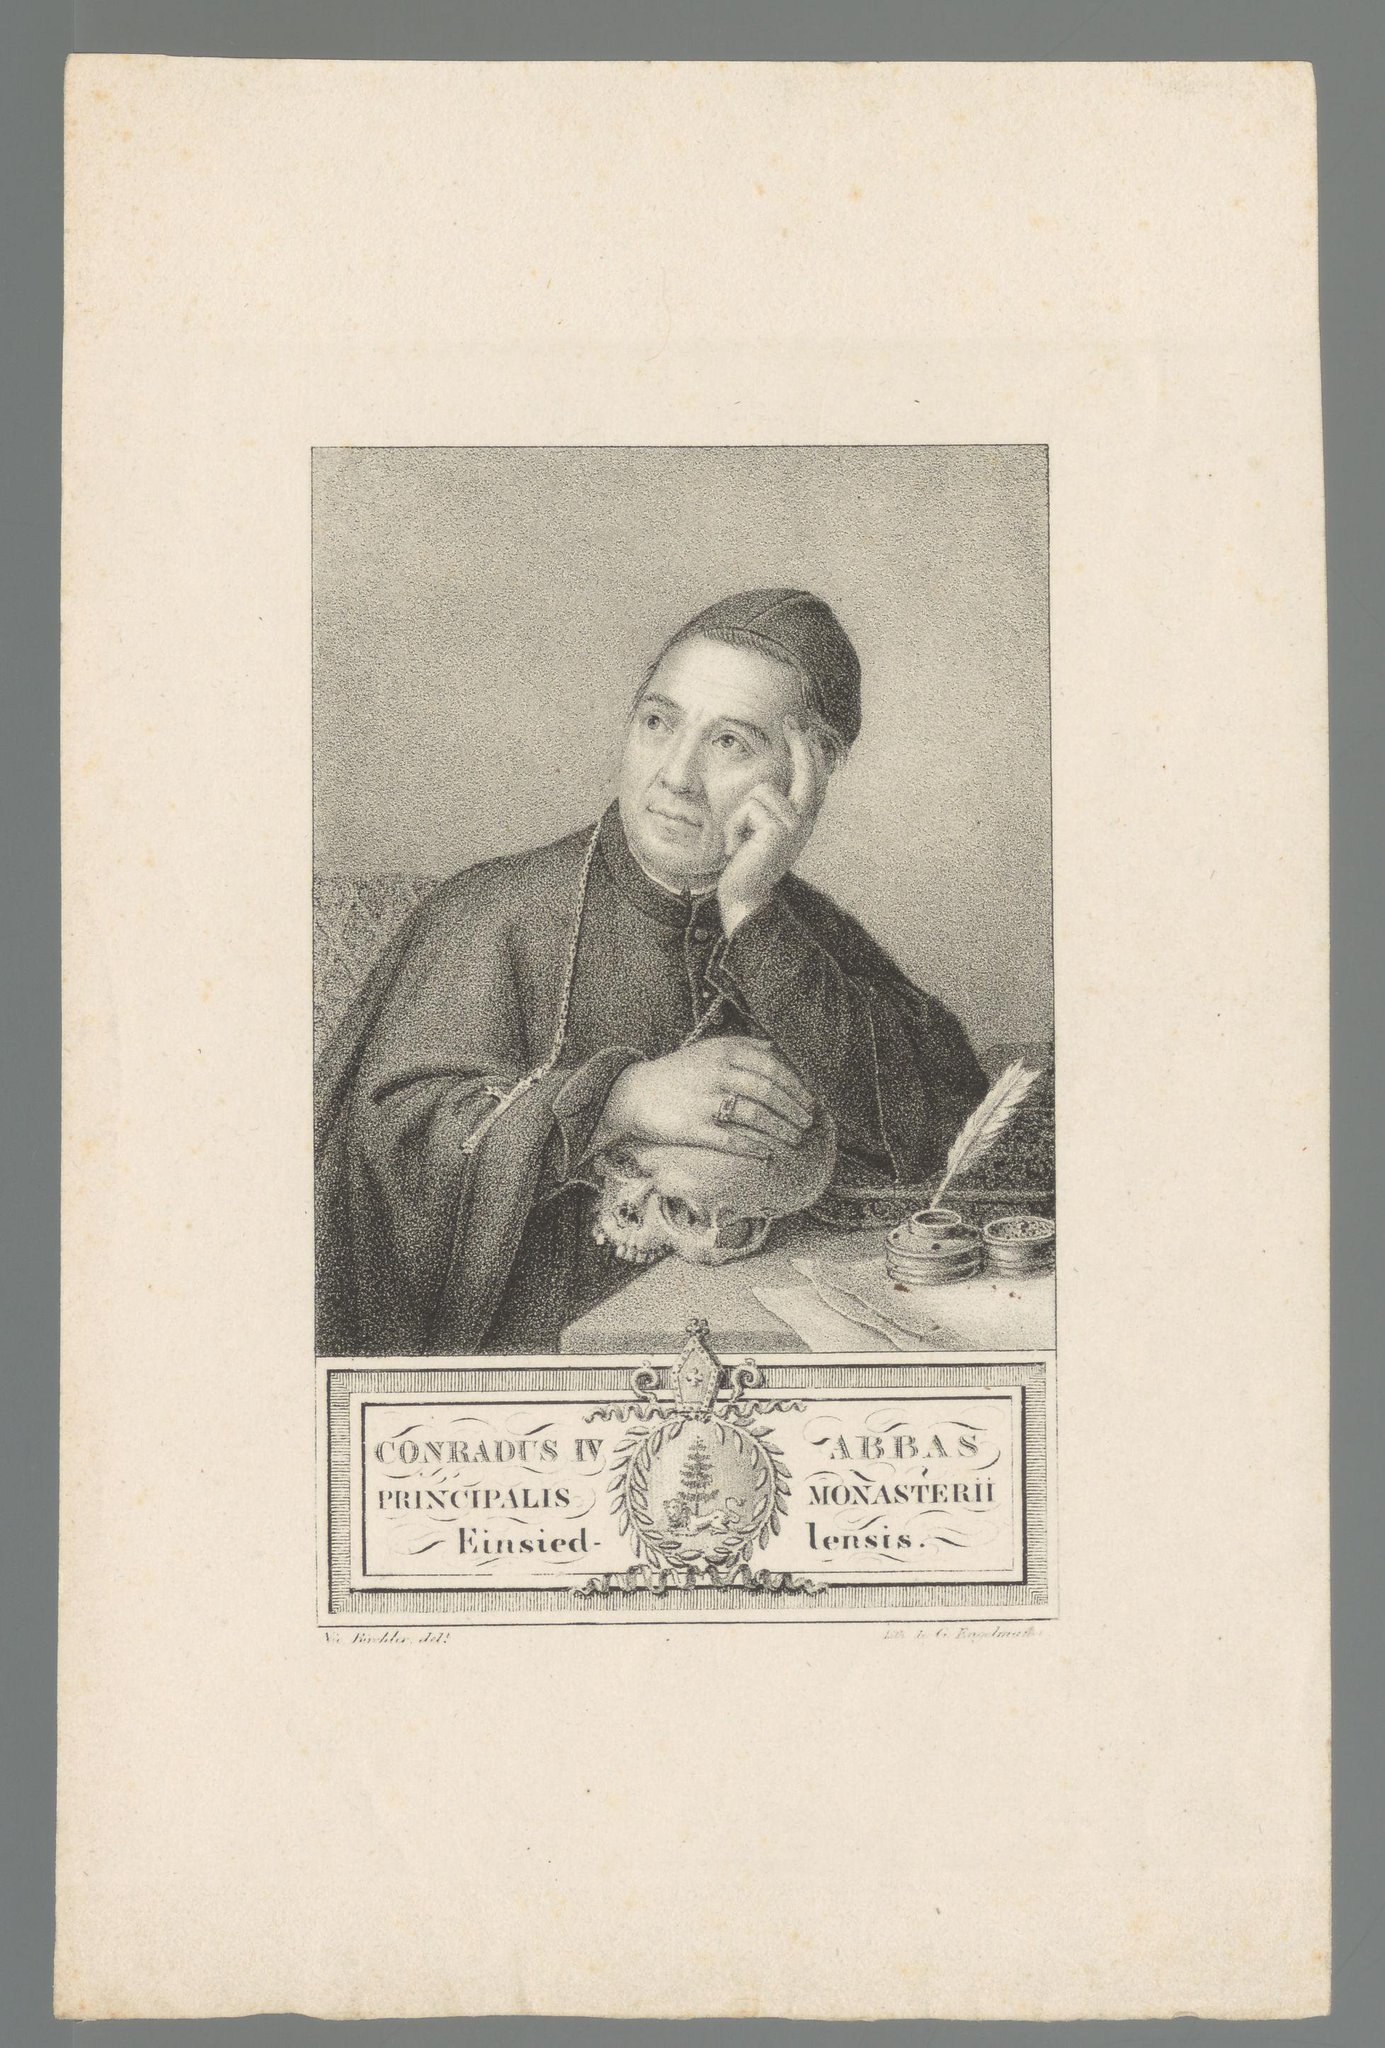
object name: print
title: Portret van Conrad Abbas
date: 1810-1857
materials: paper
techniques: lithograph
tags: clergyman, adult man, historical persons, meditation over skull and/or crucifix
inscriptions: collector's mark: Lugt 2228